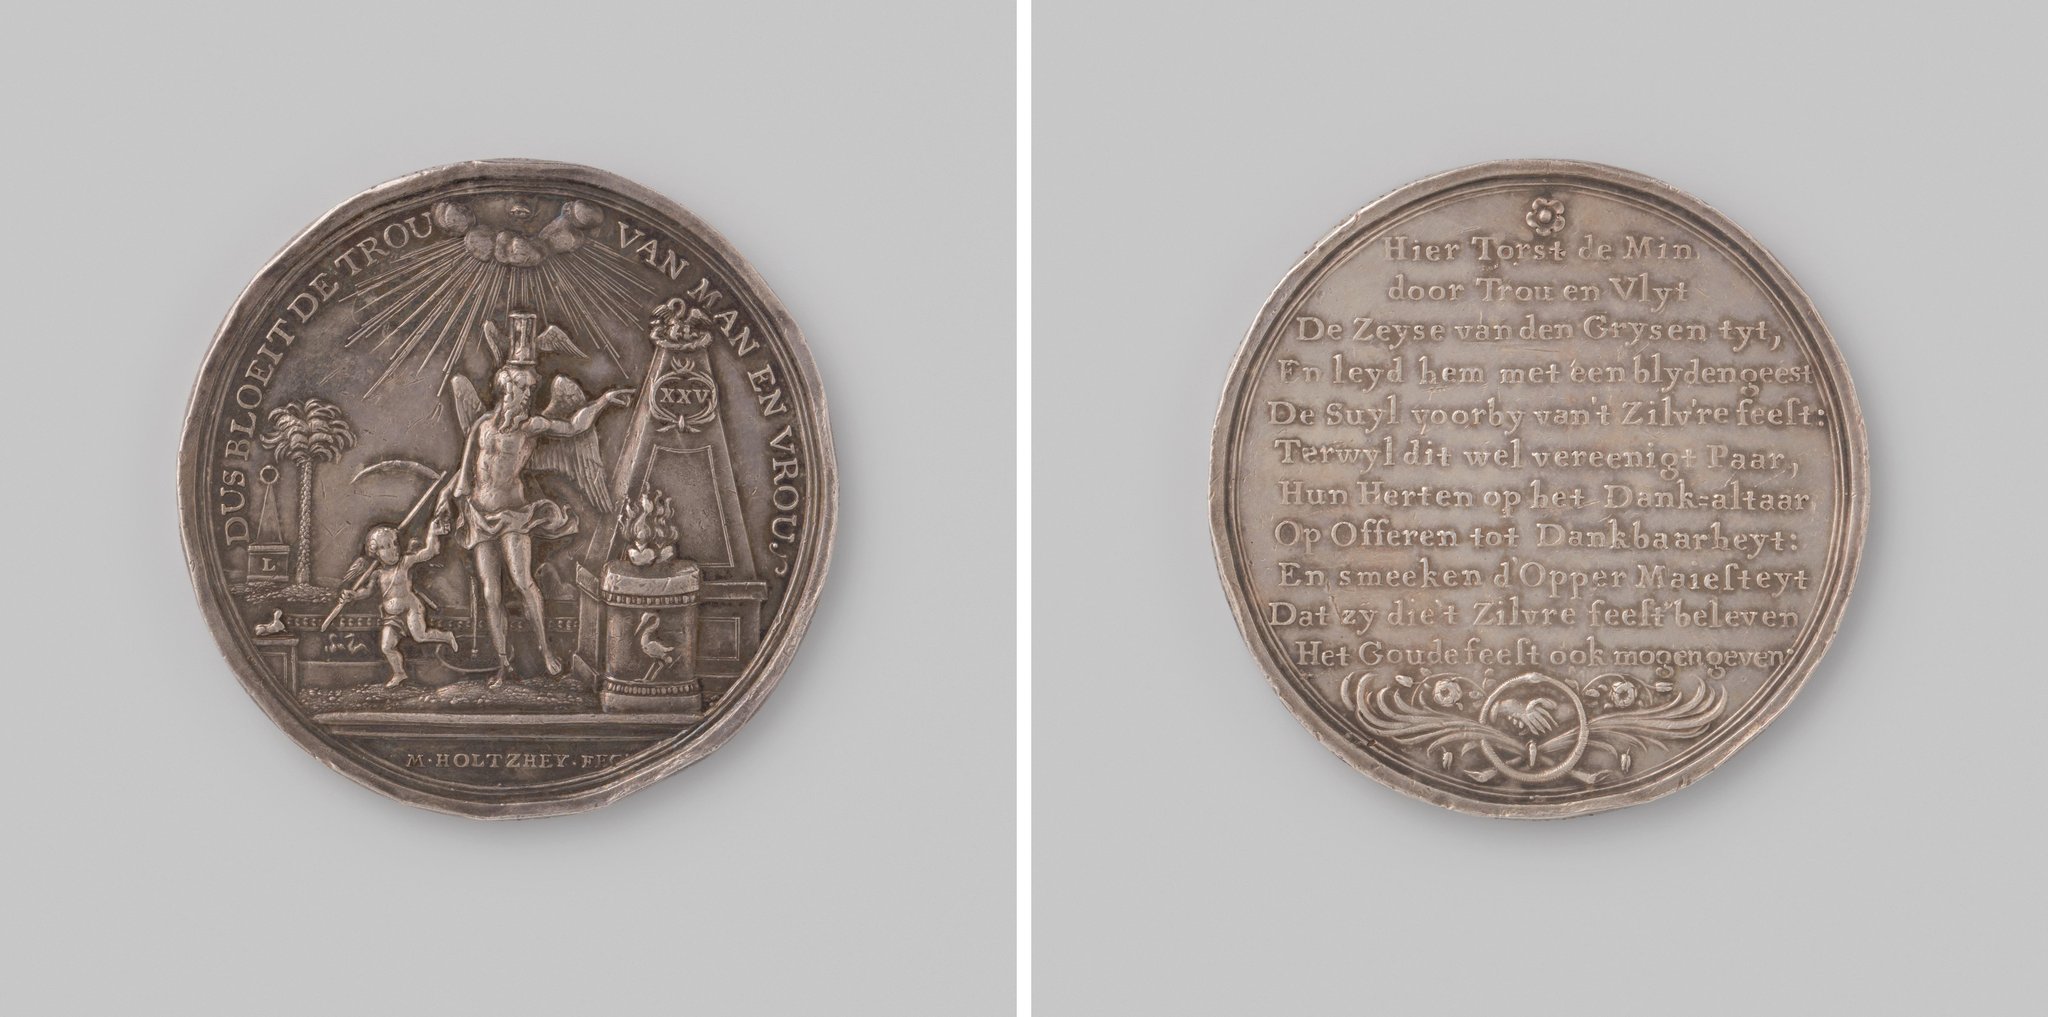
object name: history medal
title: Algemene huwelijkspenning met randinscriptie op het vijfentwintigjarig huwelijk van Jacobus Hancock en Geertruy Elisabet Romer 1803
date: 1803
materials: silver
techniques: engraving, striking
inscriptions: inscription: ‘IACOBUS HANCOCK en GEERTRUY ELISABET ROMER GETROUWT 12 MAY 1778 'T ZILVERE FEEST GEVIERT 1803’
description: Zilveren algemene huwelijkspenning, op de voorzijde Cupido met zeis die, de Tijd meevoert van een pyramide waarop XXV naar een verderop beschreven L, in een lusthof onder een stralende hemel met rechts een altaar met brandende harten, met omschrift en afsnedetekst, op de keerzijde elf regels tekst, bovenaan een roos, onderaan een handdruk in slangenrond met samengebonden palmbladeren en rozen, in de rand een gelegenheidsinscriptie.